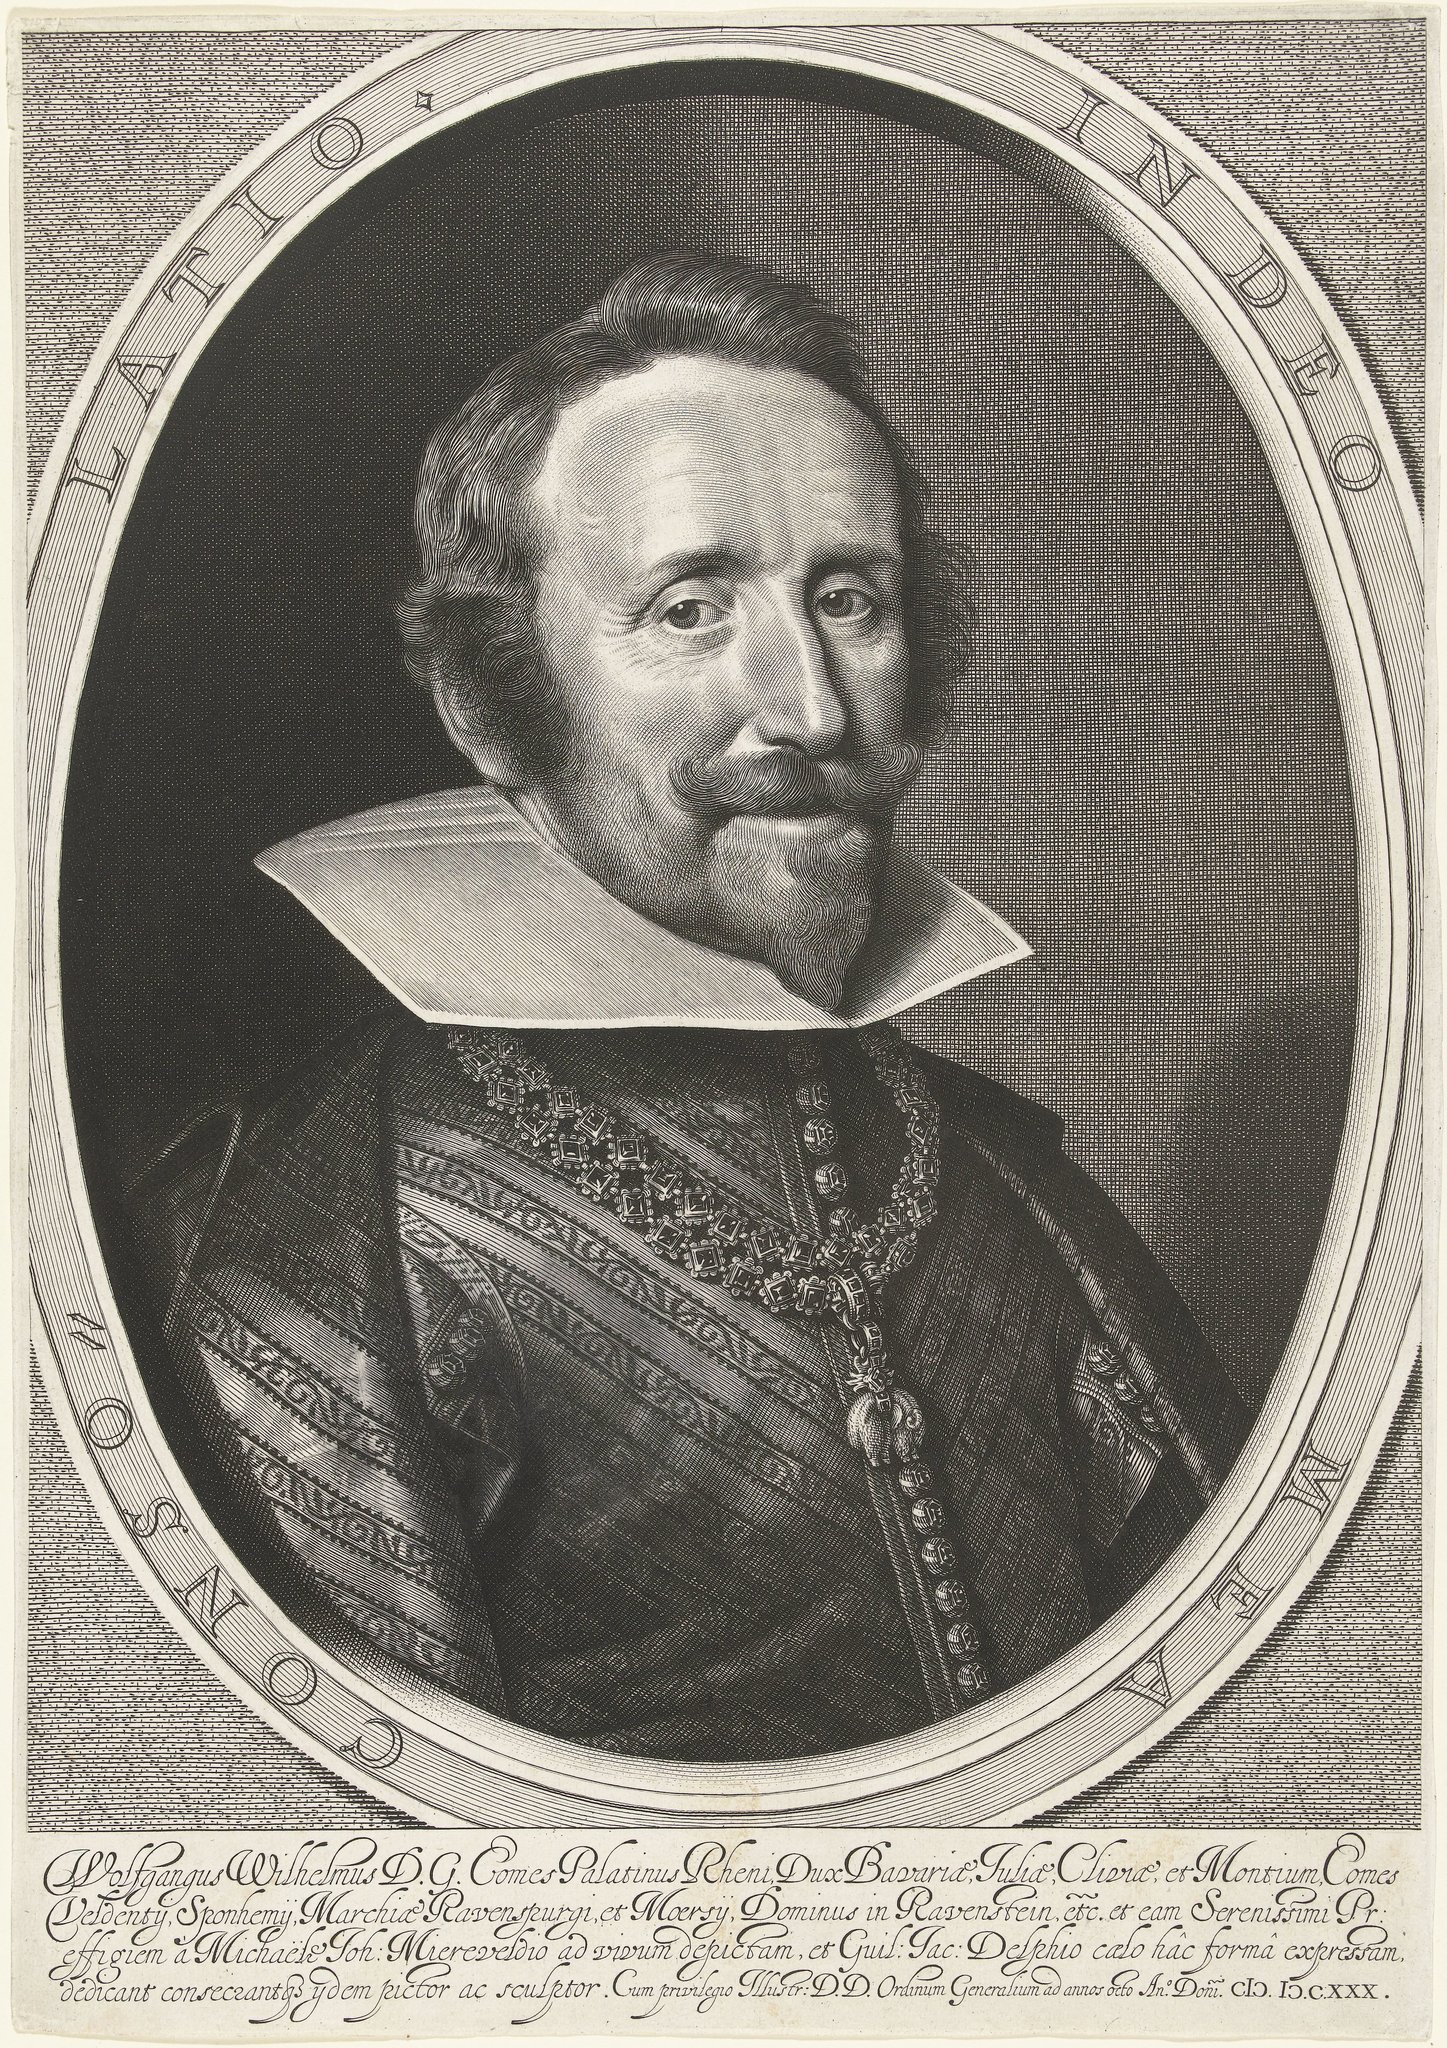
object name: print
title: Portret van Wolfgang Willem van de Palts-Neuburg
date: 1630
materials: paper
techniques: engraving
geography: delft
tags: wolfgang willem van de palts-neuburg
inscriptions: collector's mark: Lugt 963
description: Portret van Wolfgang Willem van de Palts-Neuburg, borststuk met keten van Ridderorde van het Gulden Vlies in ovale omlijsting met Latijns motto. In ondermarge Latijns opschrift in vier regels.